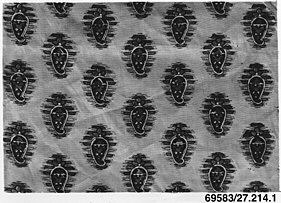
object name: sample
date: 1801-1900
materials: cotton